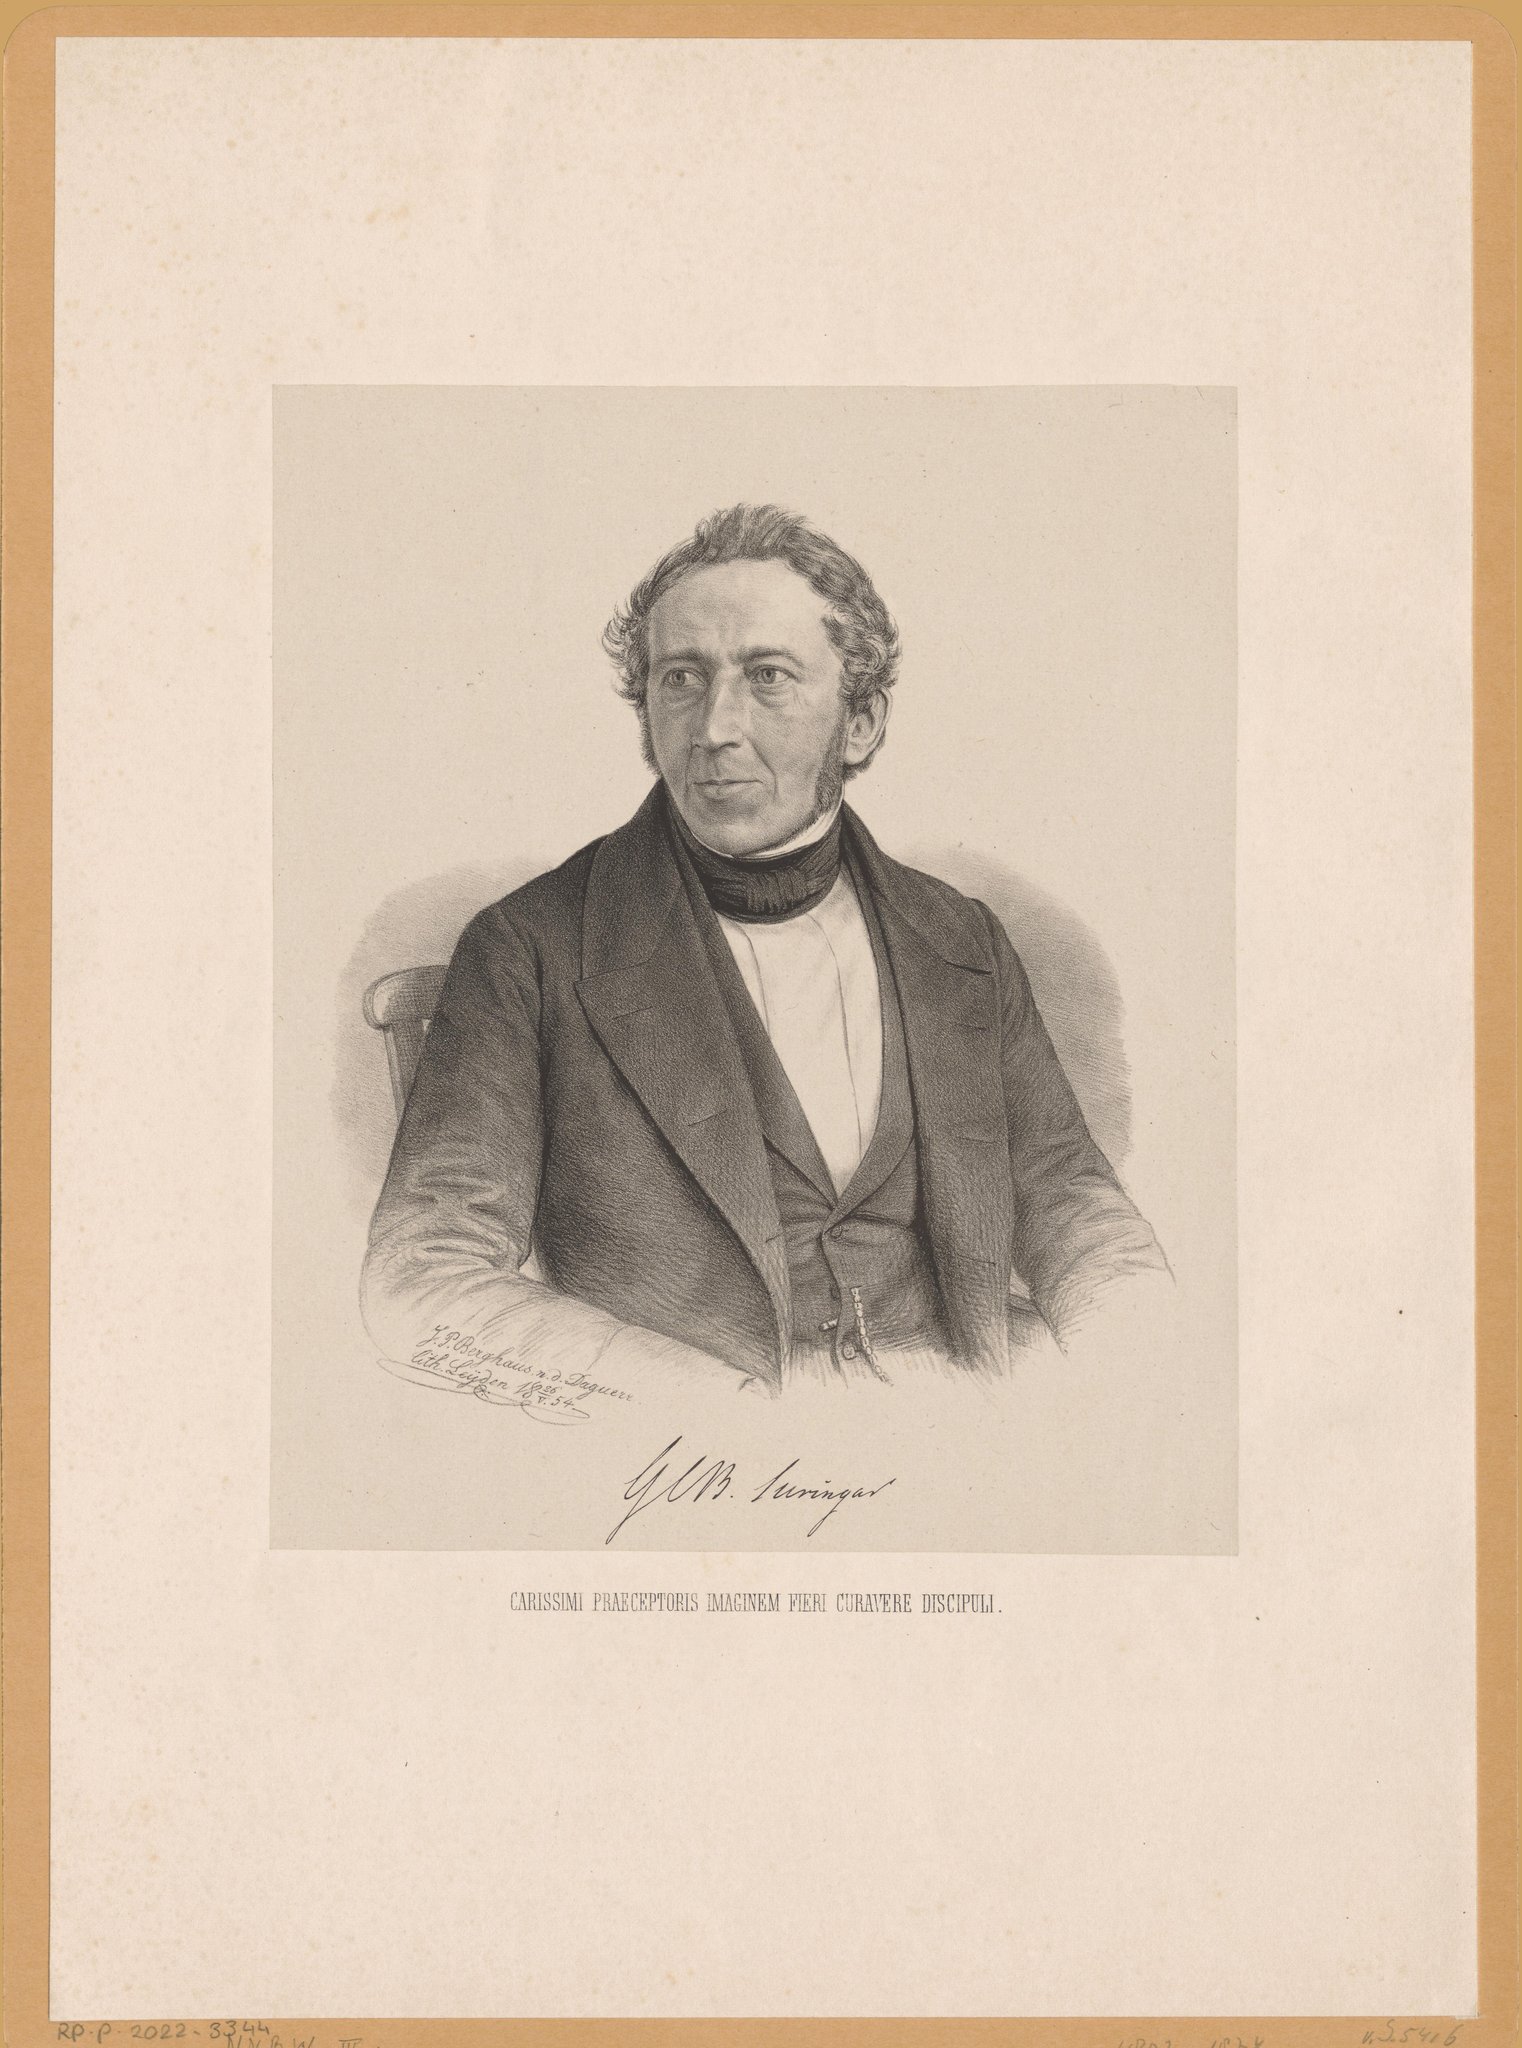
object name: print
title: Portret van Gerard Conrad Bernard Suringar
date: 1854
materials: paper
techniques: lithograph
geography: leiden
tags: leiden, historical persons, physician, doctor, professor